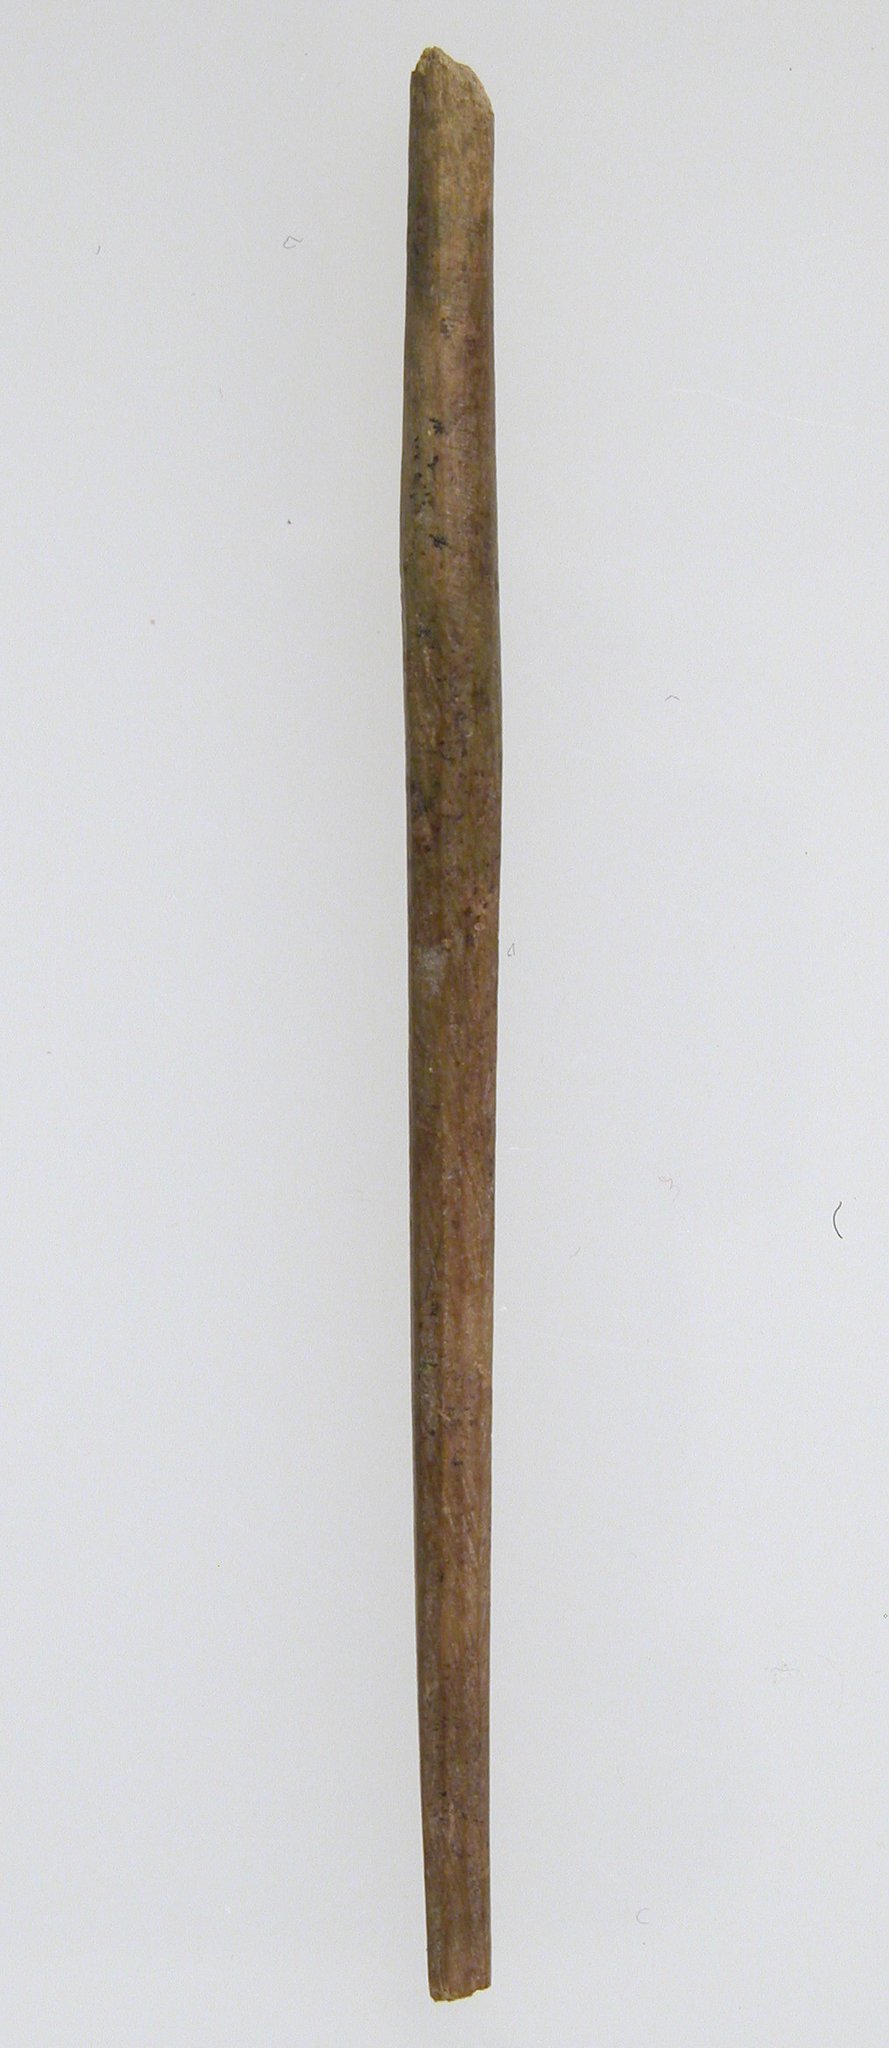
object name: hairpin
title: Part of Hairpin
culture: roman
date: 200-500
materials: bone